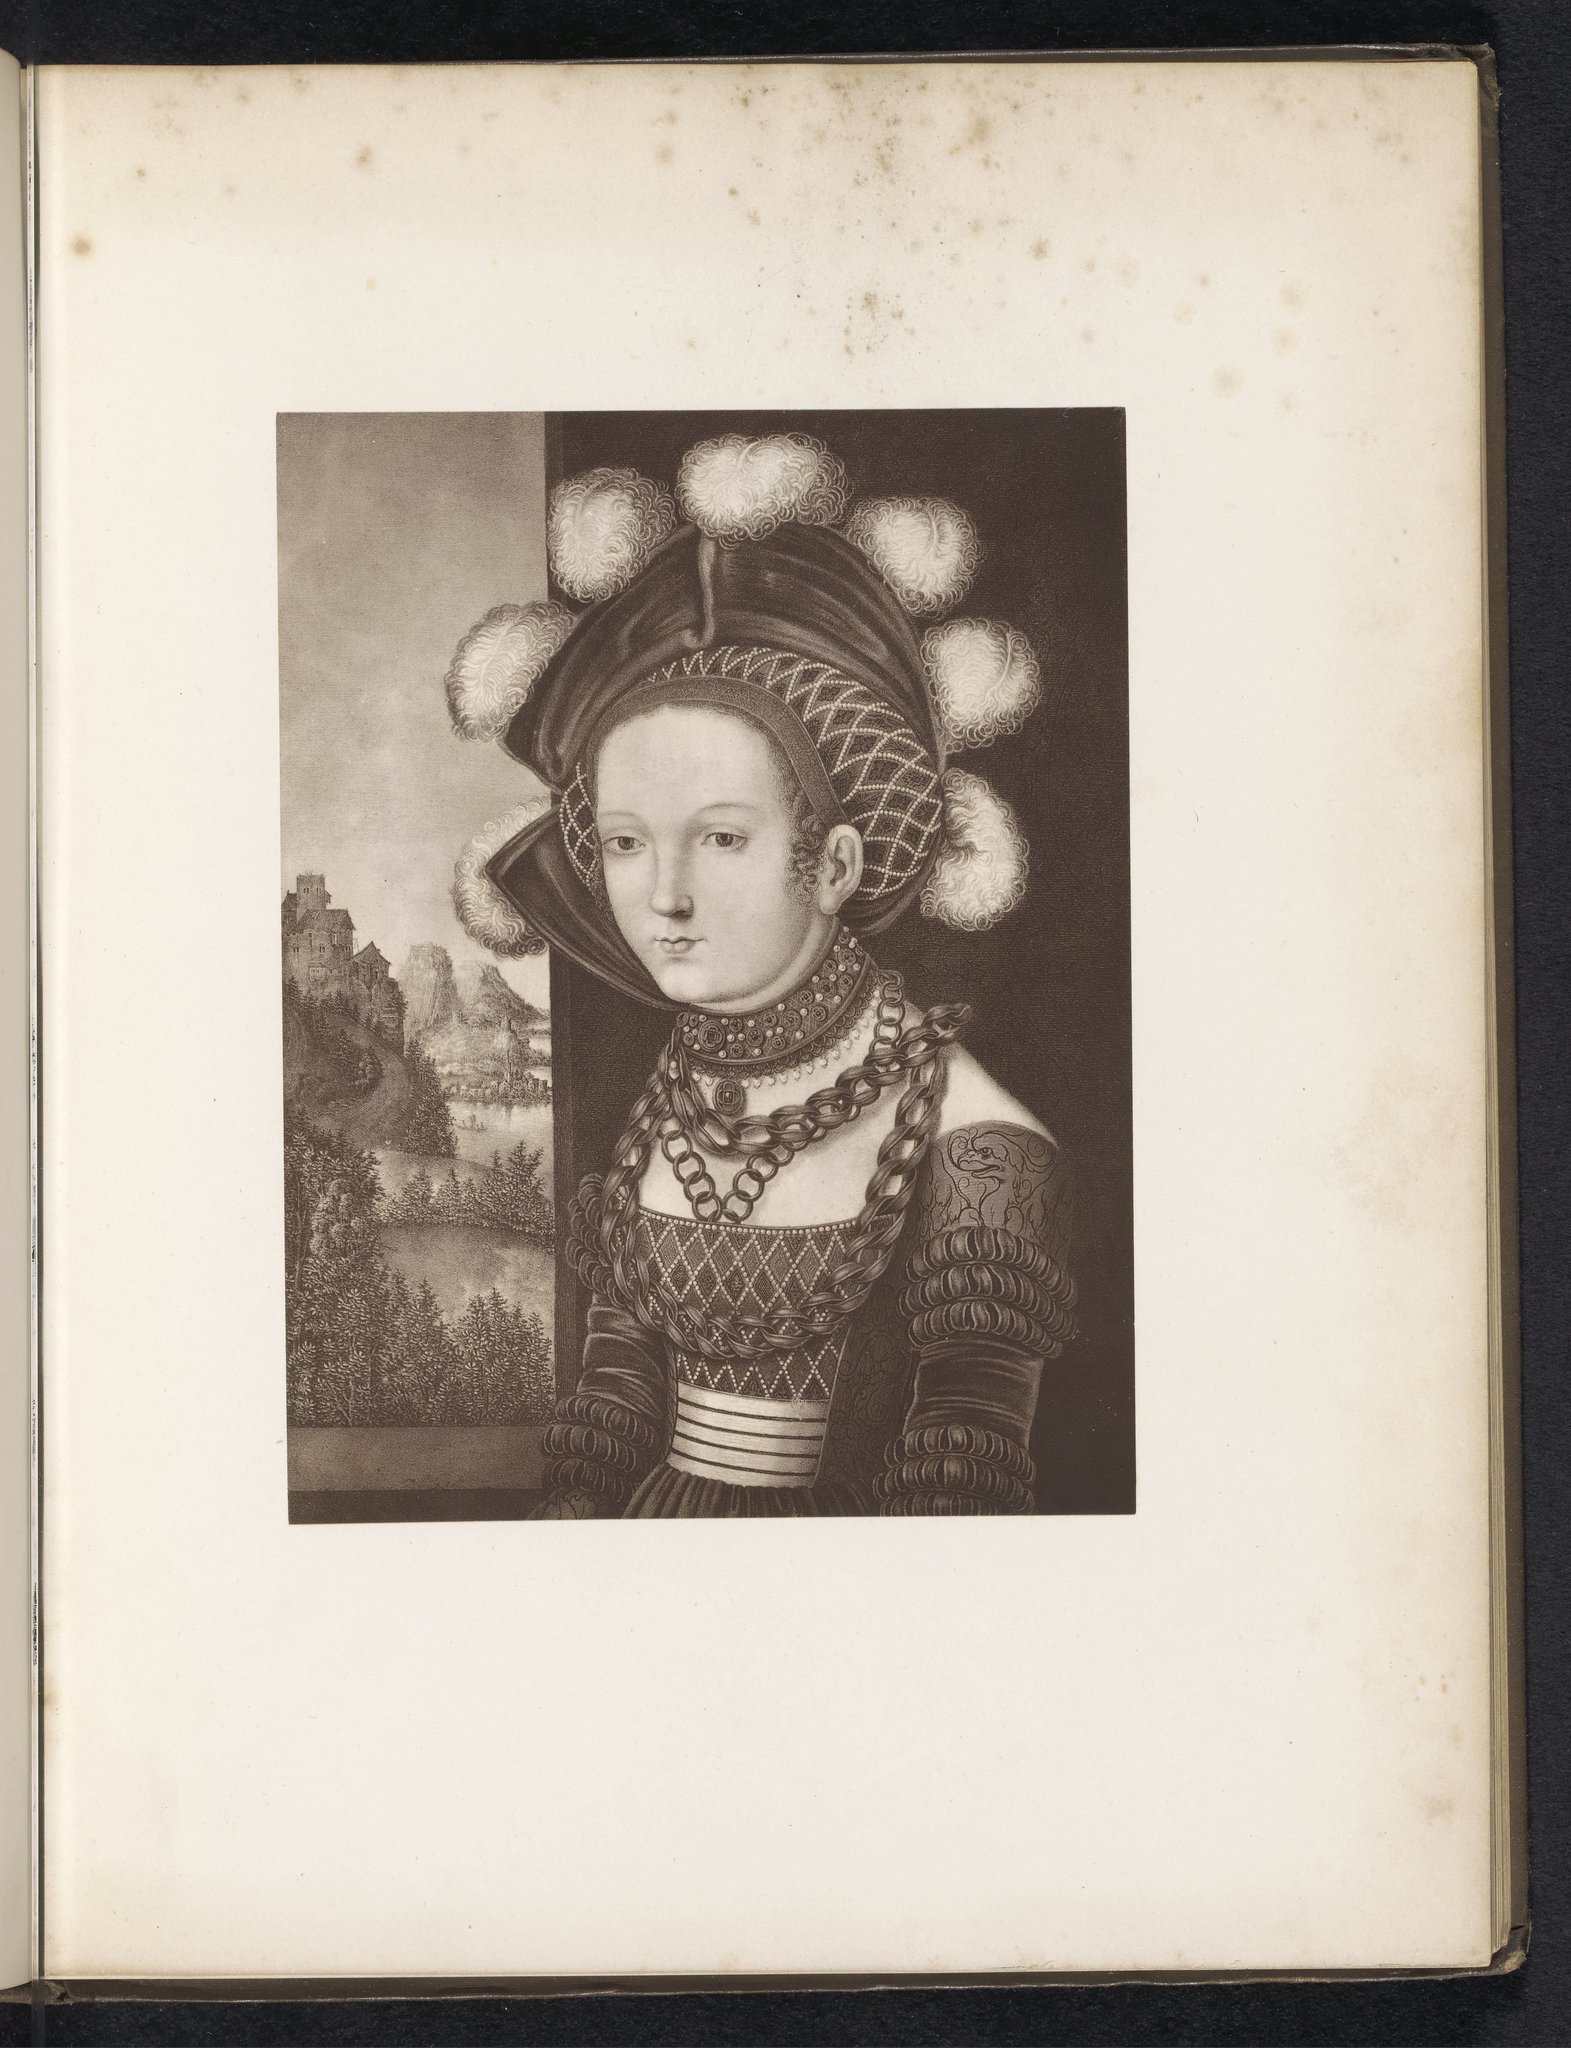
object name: page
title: Fotoreproductie van een prent naar een schilderij, voorstellende een hofdame verkleed als Salomé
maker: Anonymous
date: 1859-1869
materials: photographic support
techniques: albumen print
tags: salome (not in biblical context), historical persons not known by name - bb - woman